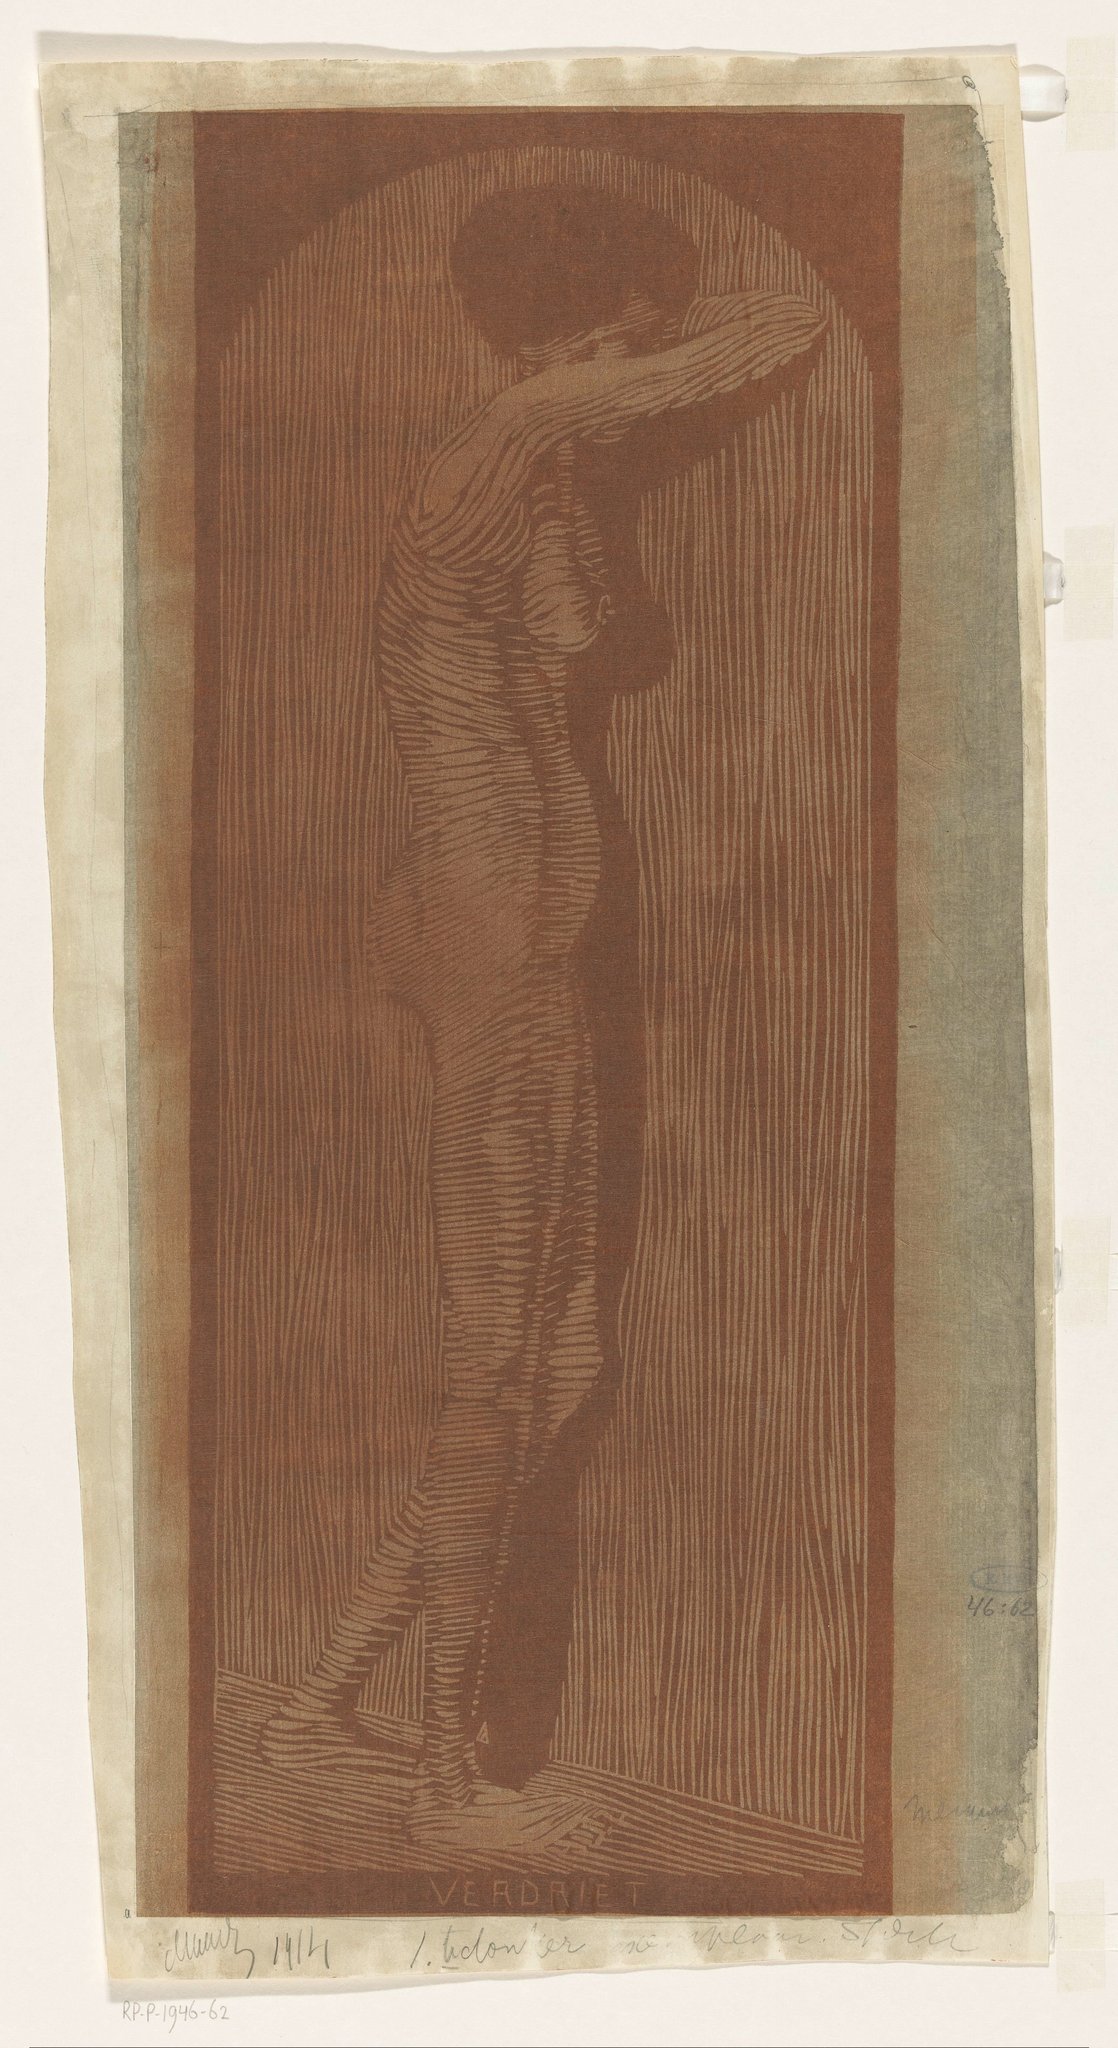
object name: print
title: Verdriet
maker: samuel jessurun de mesquita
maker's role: draughtsman, print maker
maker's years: 1868-1944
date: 1903-1914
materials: paper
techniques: woodcut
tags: woman (showing herself) undressed, quasi-nude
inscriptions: collector's mark: Lugt 2228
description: Een naakte vrouw staat met haar arm voor haar gezicht tegen een muur geleund.